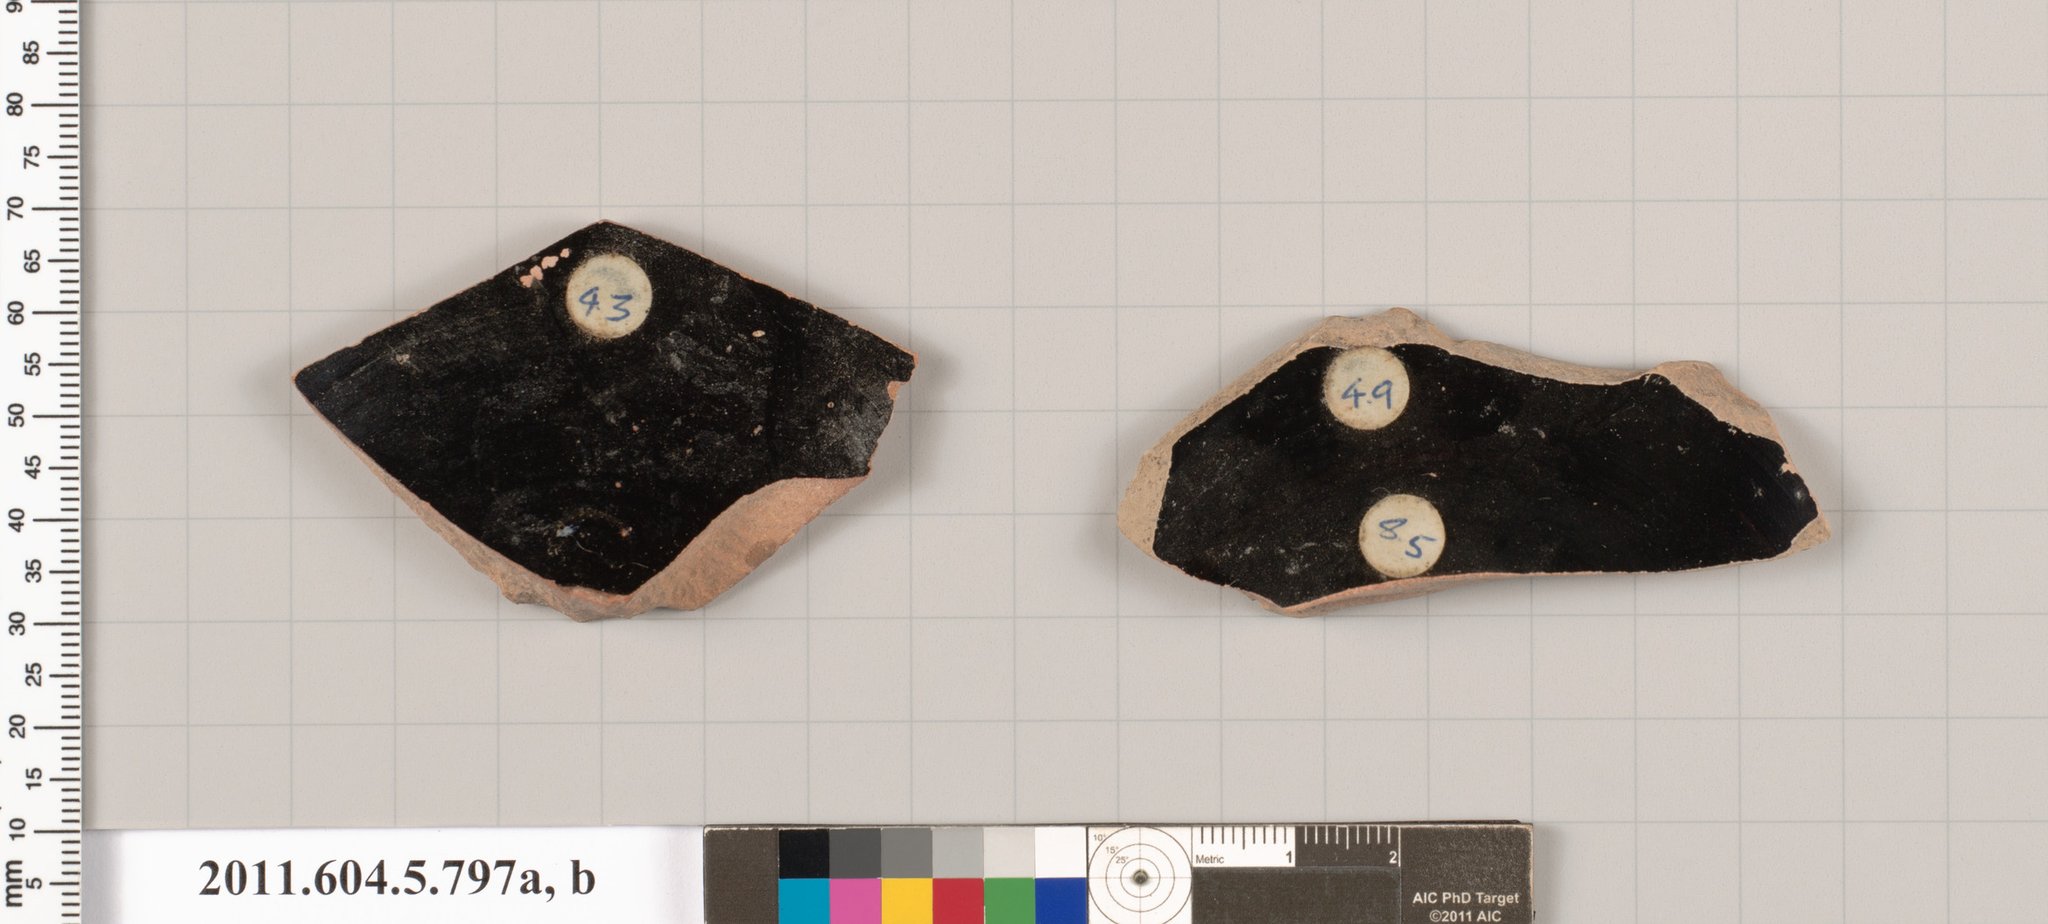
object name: kylix fragment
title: Terracotta fragments of kylikes (drinking cups)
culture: greek, attic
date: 600-401 BCE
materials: terracotta